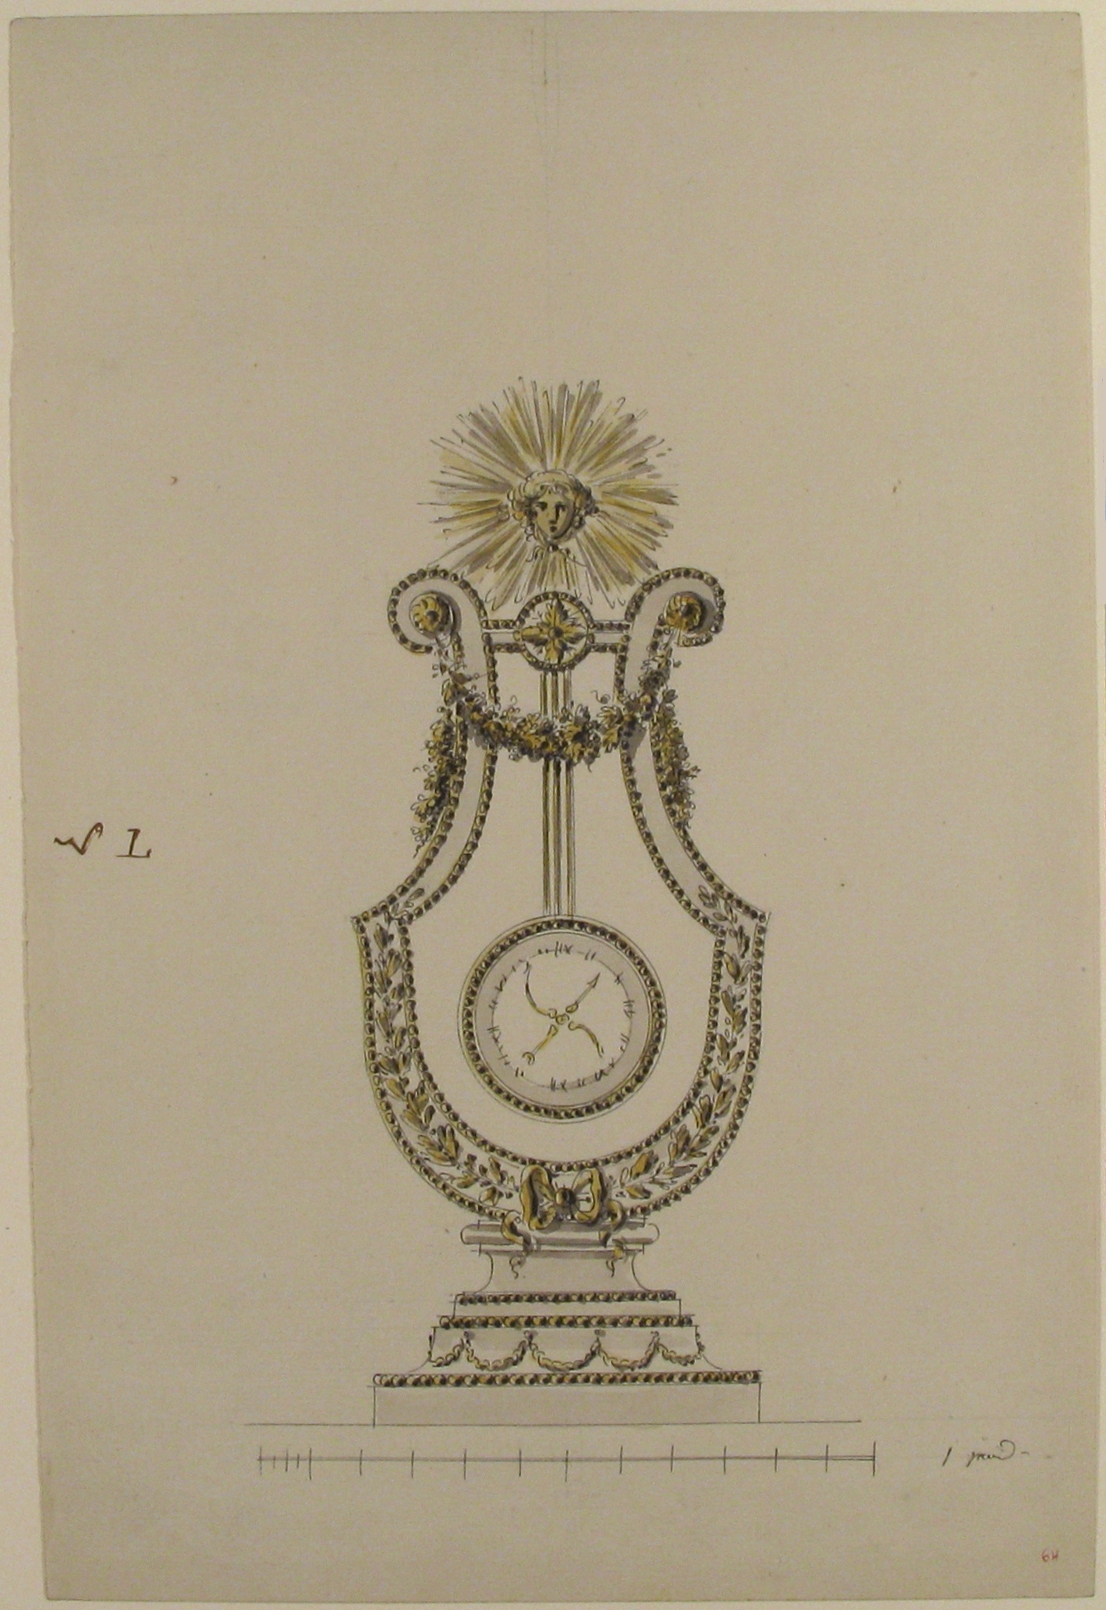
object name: drawing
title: Design for a Clock in the Form of a Lyre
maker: anonymous, french, 18th century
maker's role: artist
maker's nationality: french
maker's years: 1700-1800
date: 1775-1785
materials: graphite, ink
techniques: brush, pen, drawing, wash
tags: musical instruments,clocks